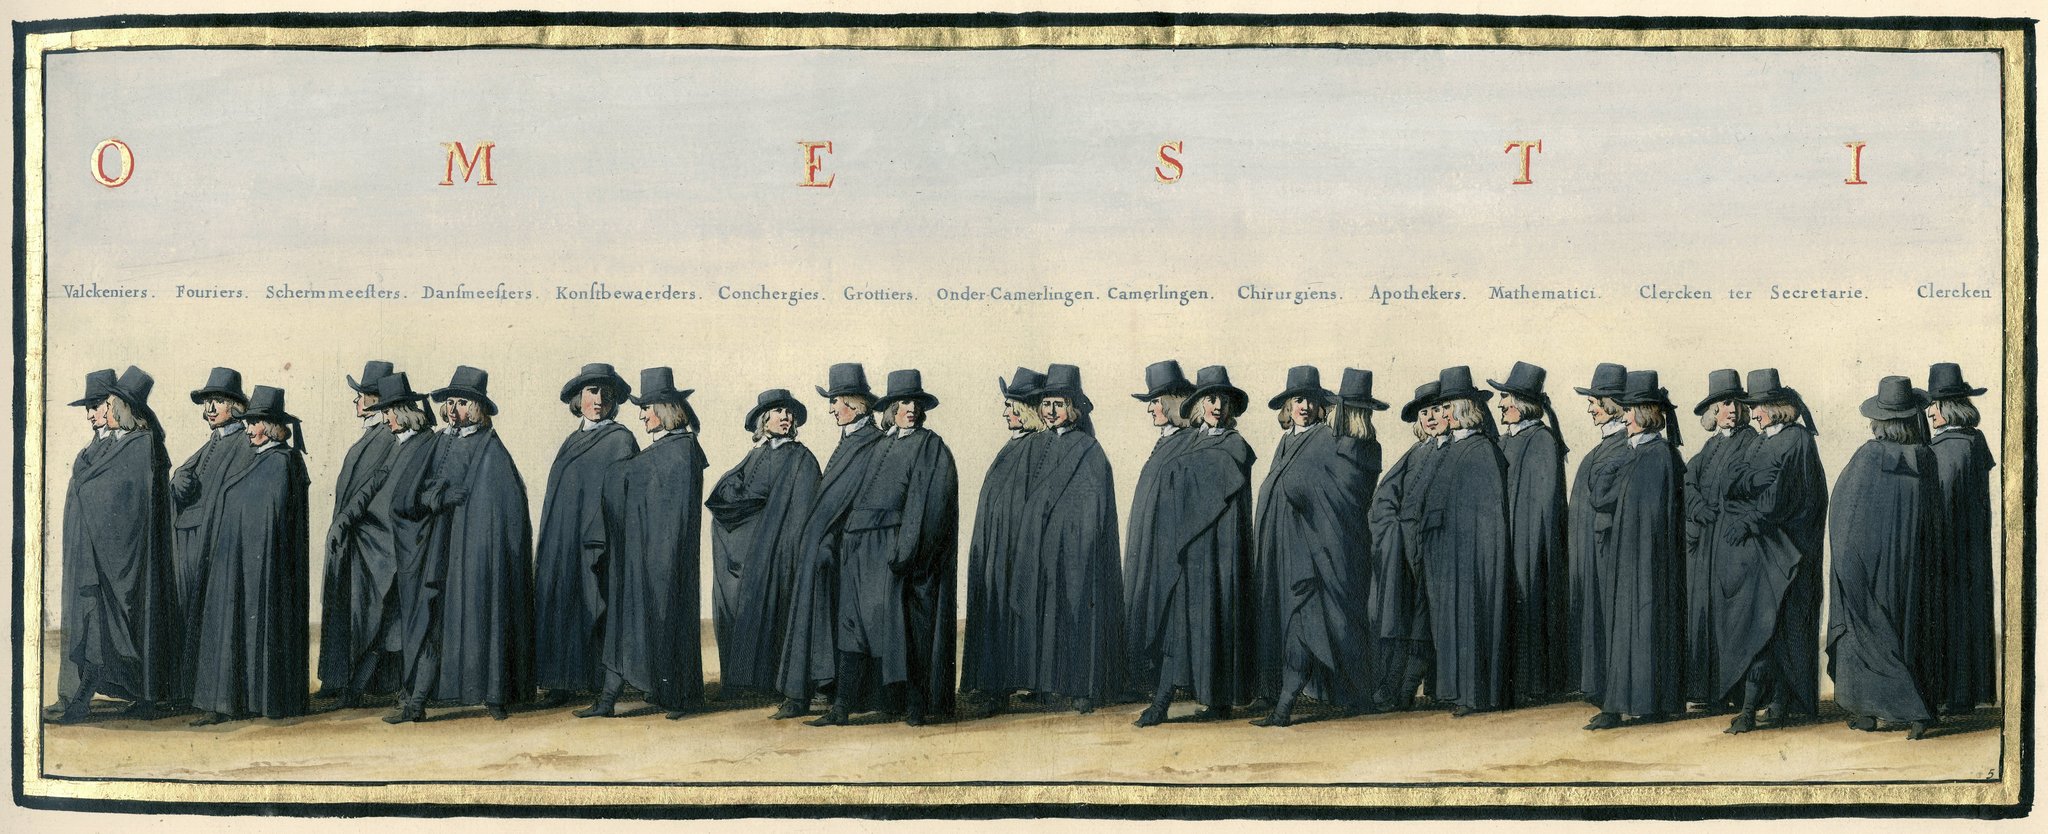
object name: print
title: Begraeffenisse van syne hoogheyt Frederick Henrick. Luxe ingekleurde uitgave van de prenten van de begrafenisstoet van Frederik Hendrik in 1647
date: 1651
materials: paint, paper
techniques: colour, etching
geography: the hague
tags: the hague, frederick henry (prince of orange)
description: De begrafenisstoet van Frederik Hendrik, plaat nr. 5. Ingekleurde prent in een omlijsting versierd met goud en ingeplakt in de luxe editie uit ca. 1755 van het boek 'Begraeffenisse van syne hoogheyt Frederick Henrick' van Pieter Post, uitgegeven te Amsterdam in 1651.